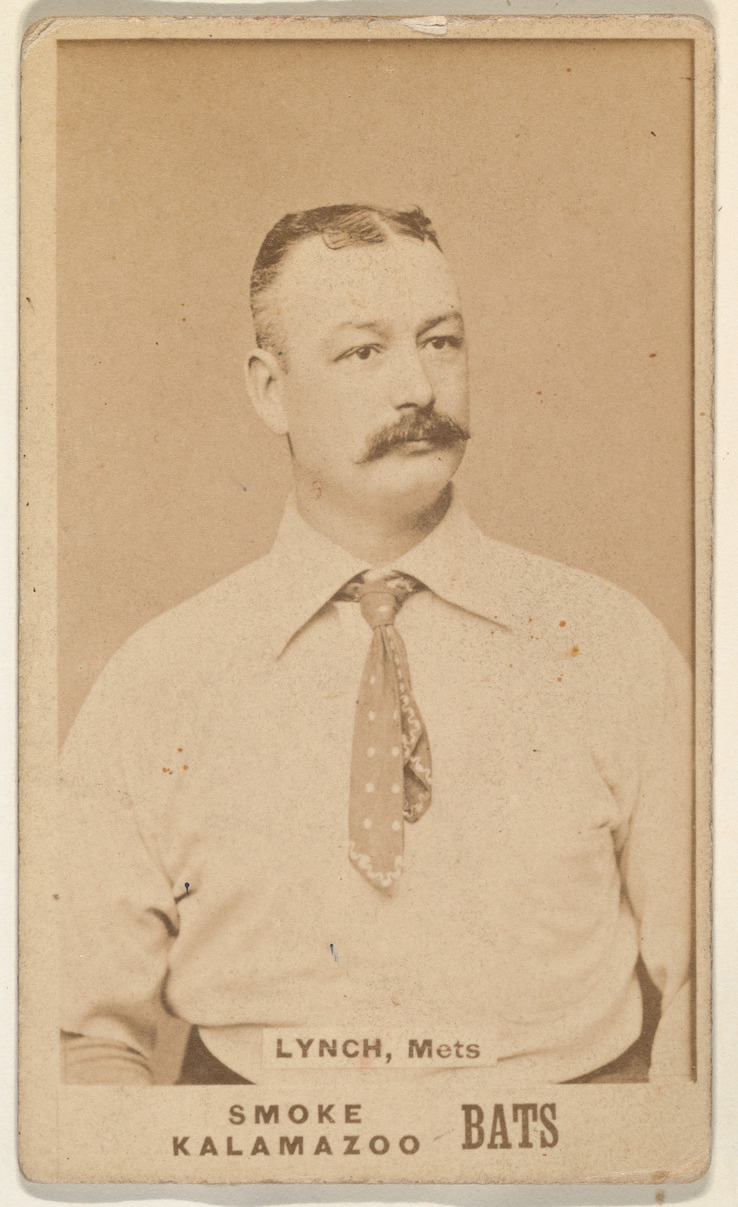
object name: baseball card, photograph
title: Lynch, Mets, from the Kalamazoo Bats series (N690) issued by Chas. Gross & Co. to promote Kalamazoo Bats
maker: chas. gross & co.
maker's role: publisher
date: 1887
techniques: albumen silver print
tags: men,portraits,baseball